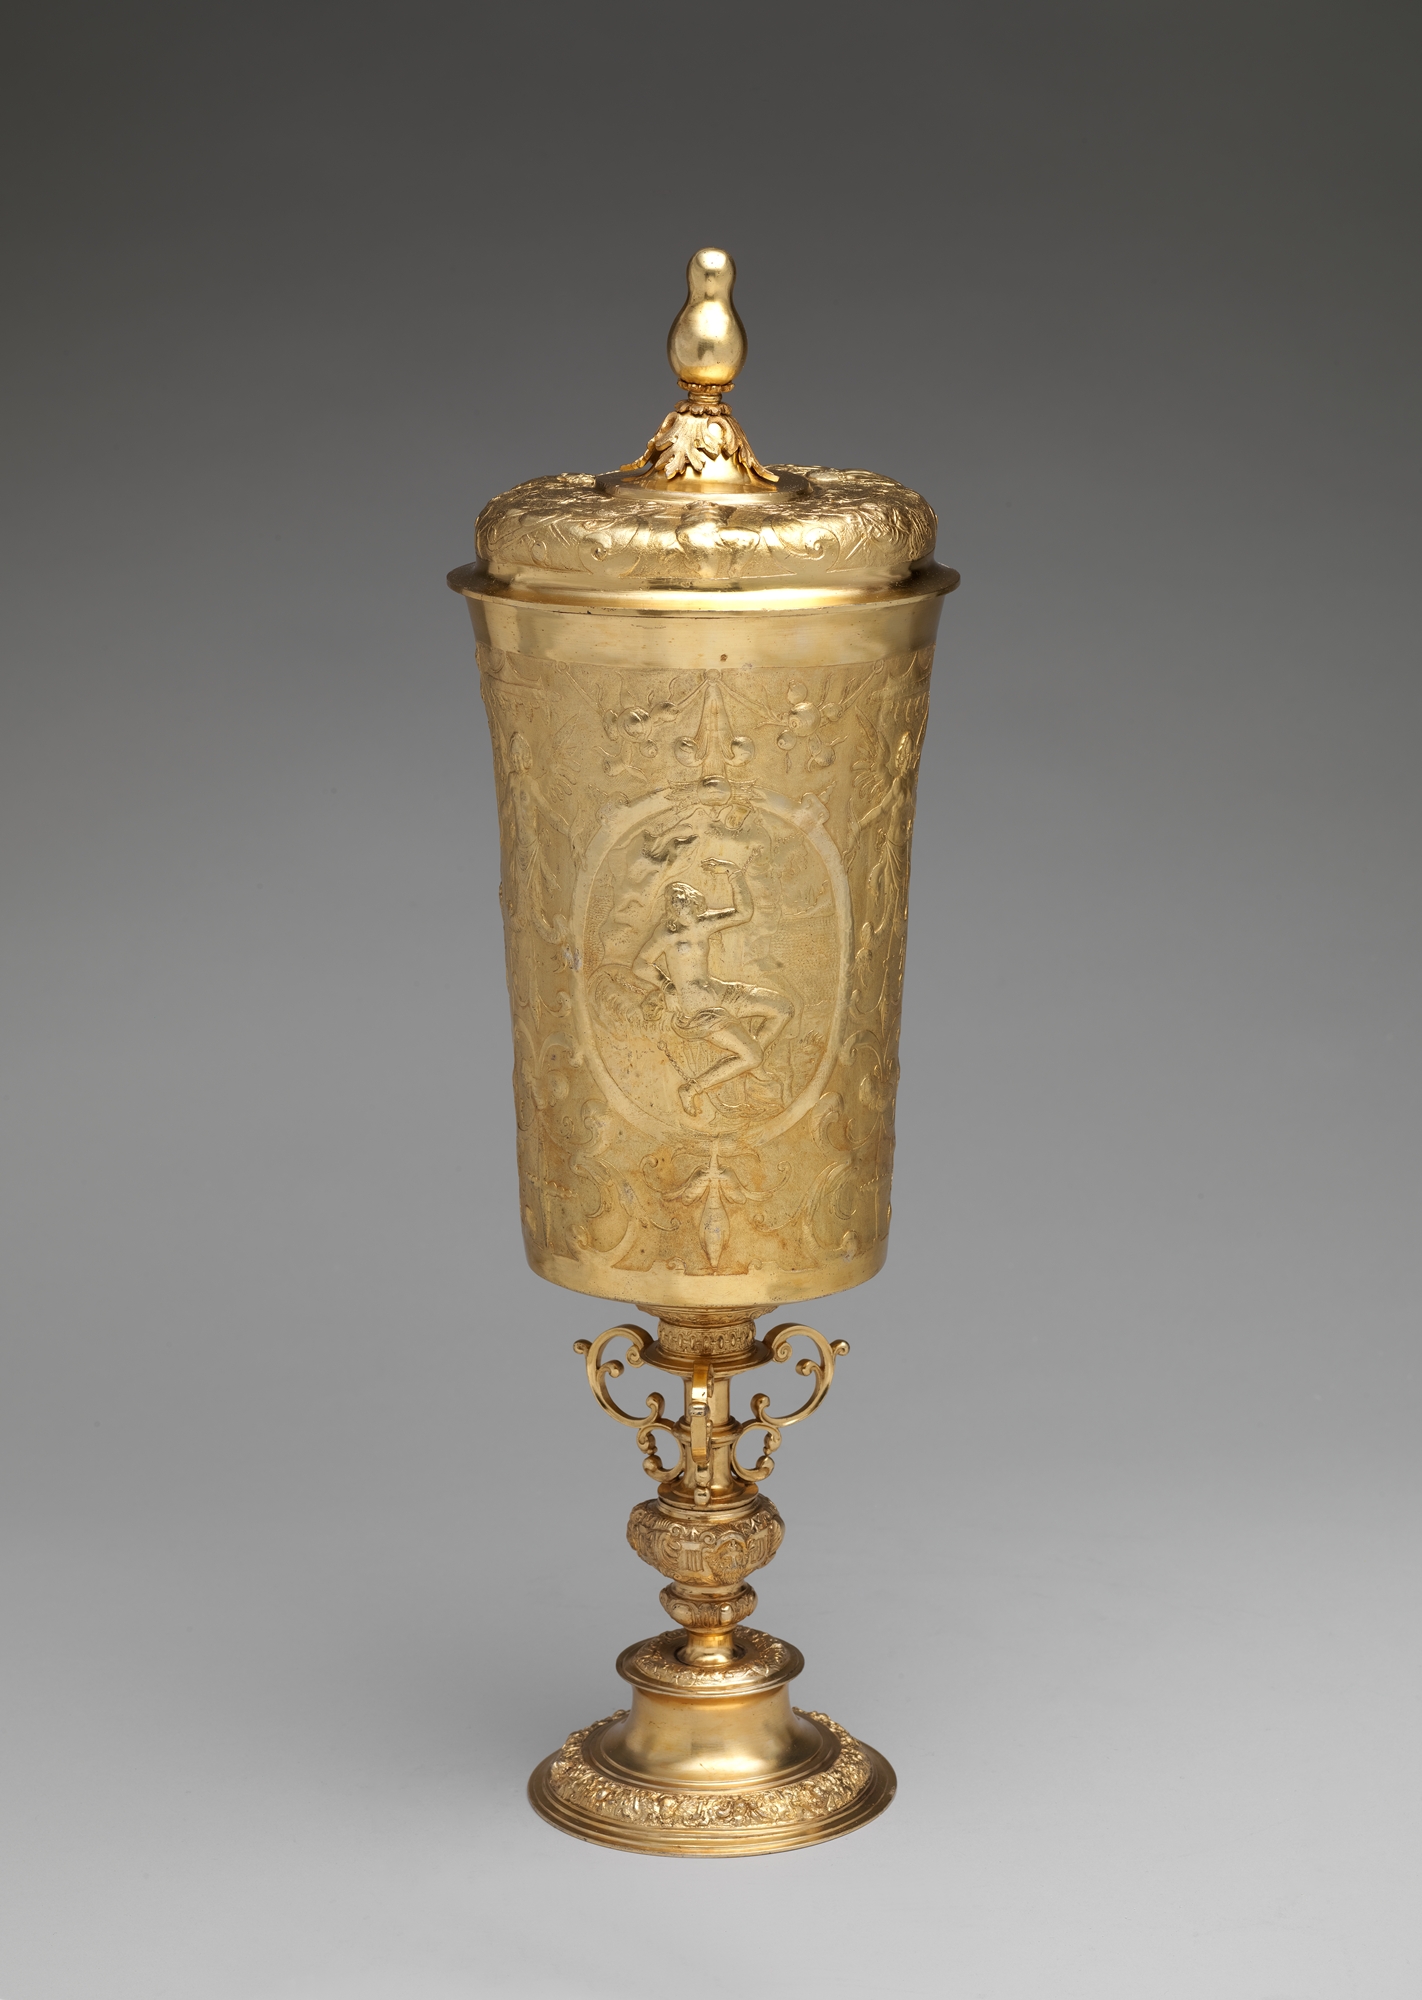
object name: cup with cover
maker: elkington & co.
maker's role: manufacturer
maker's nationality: british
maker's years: 1829-1963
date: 1801-1900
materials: metal, silver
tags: human figures,angels